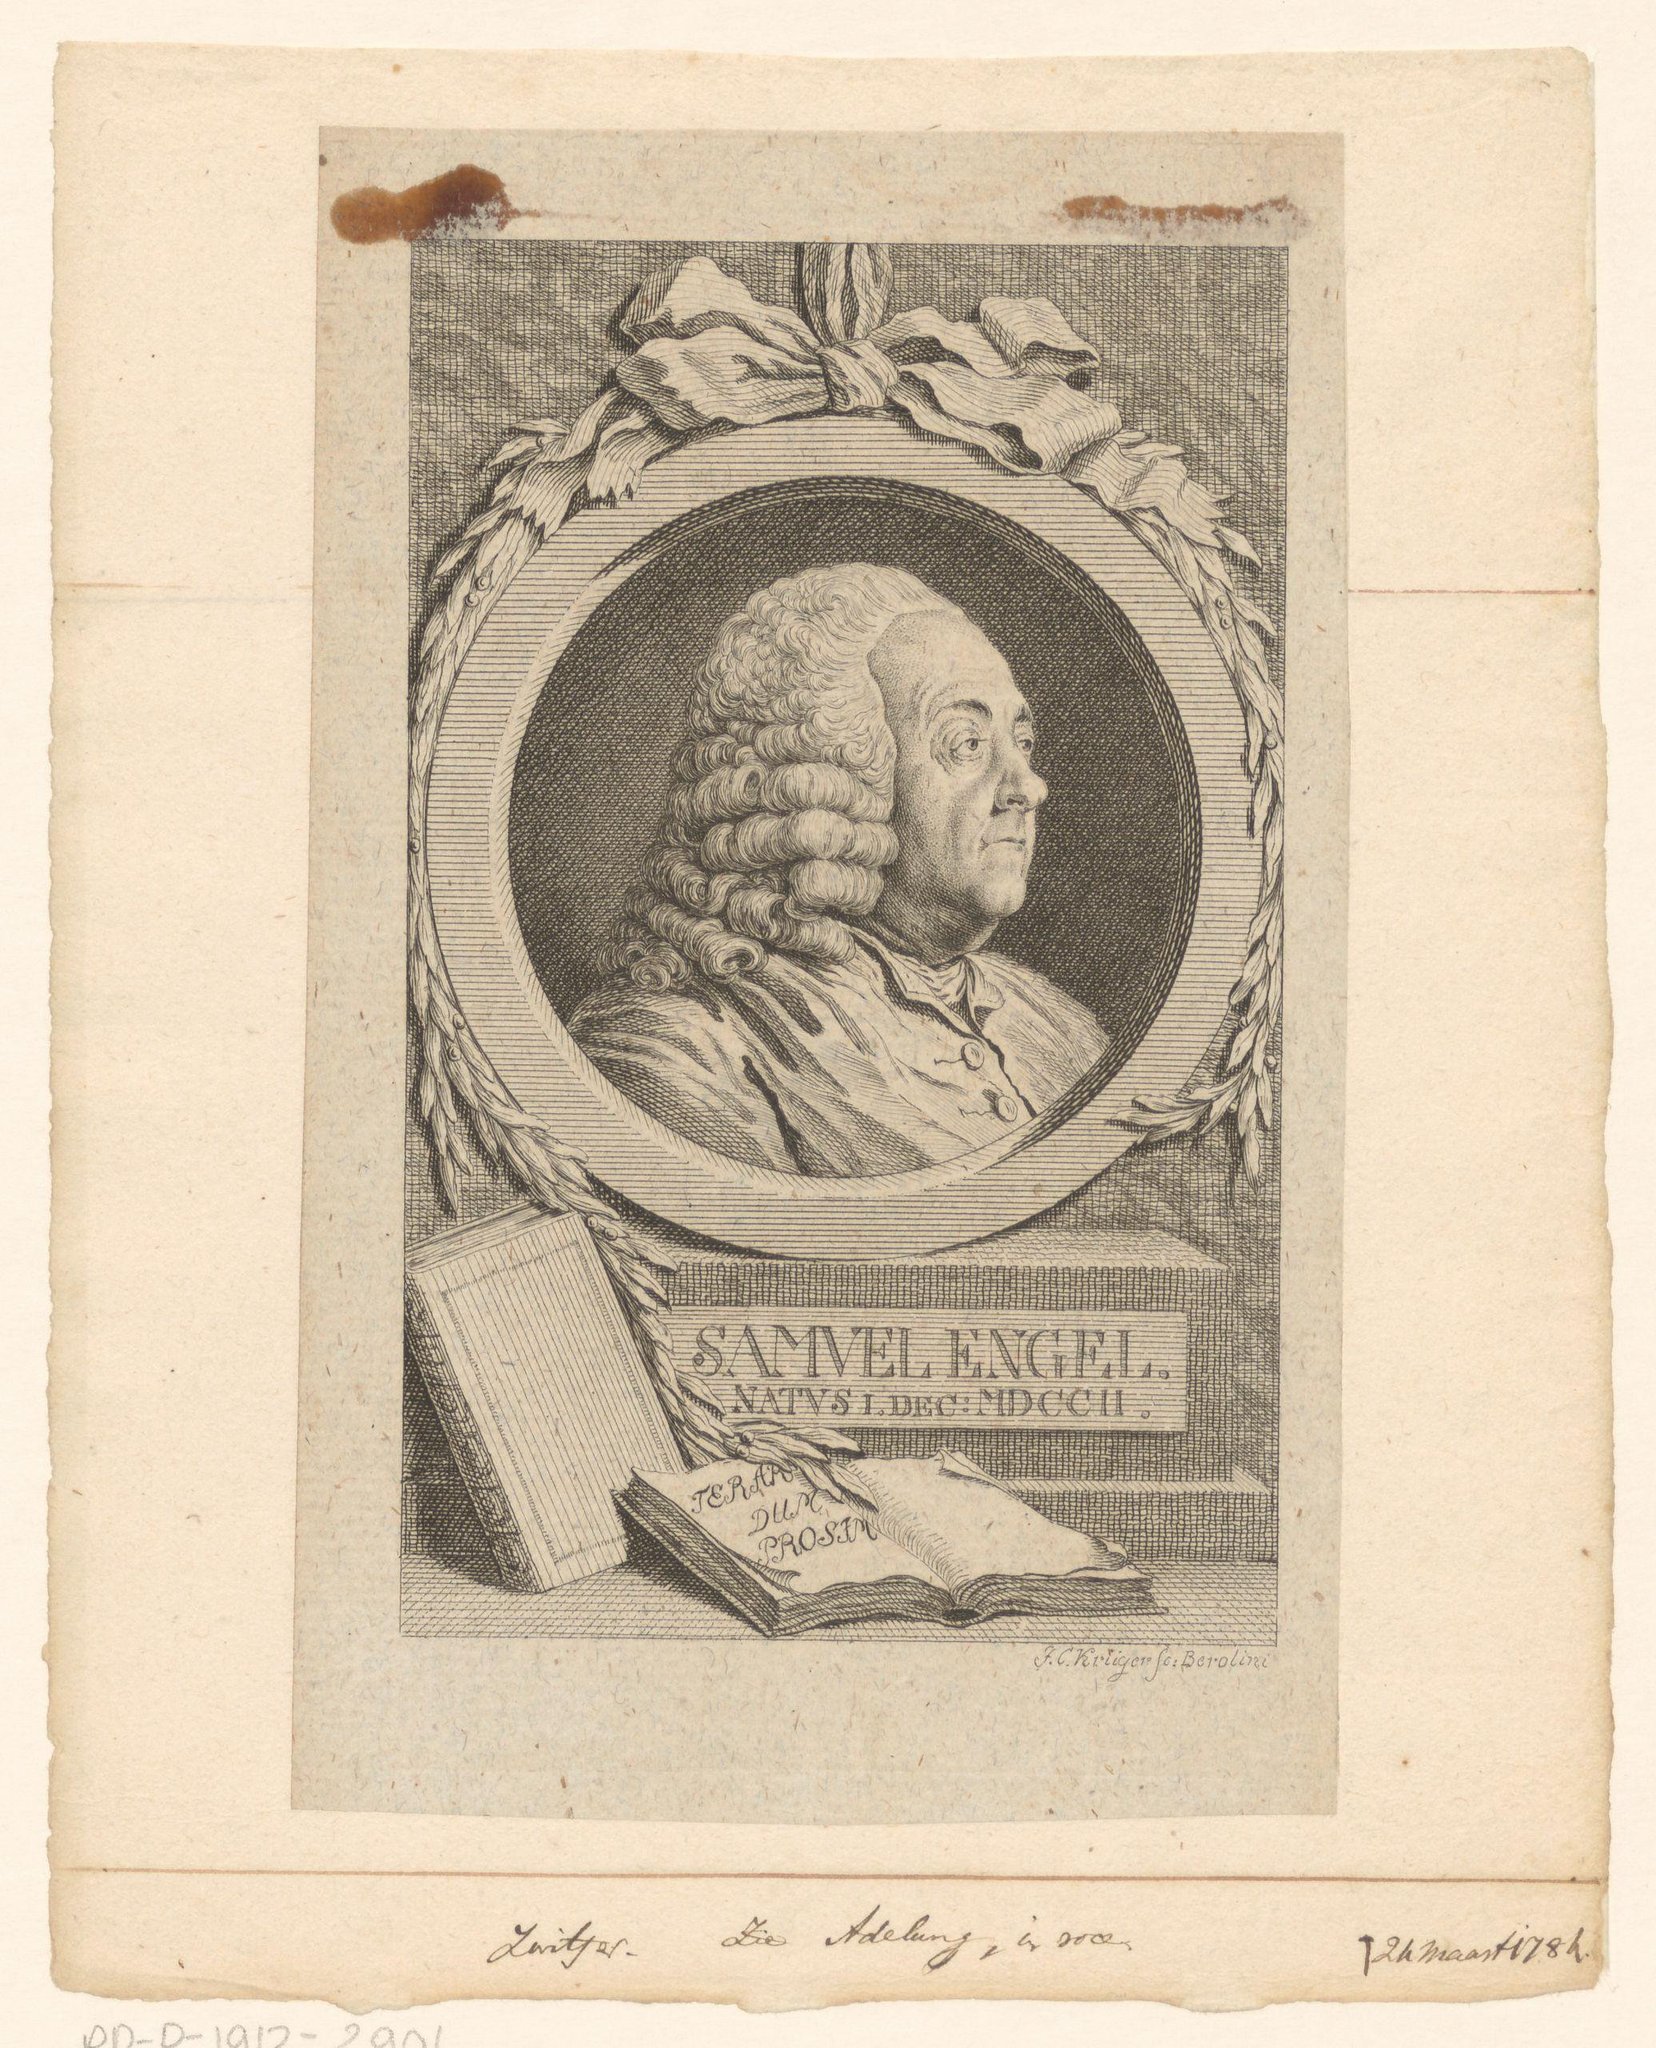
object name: print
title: Portret van Samuel Engel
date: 1781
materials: paper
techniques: engraving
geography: berlin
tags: politician, historical persons, portrait of a writer, politician, e.g. party leader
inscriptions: collector's mark: Lugt 2228